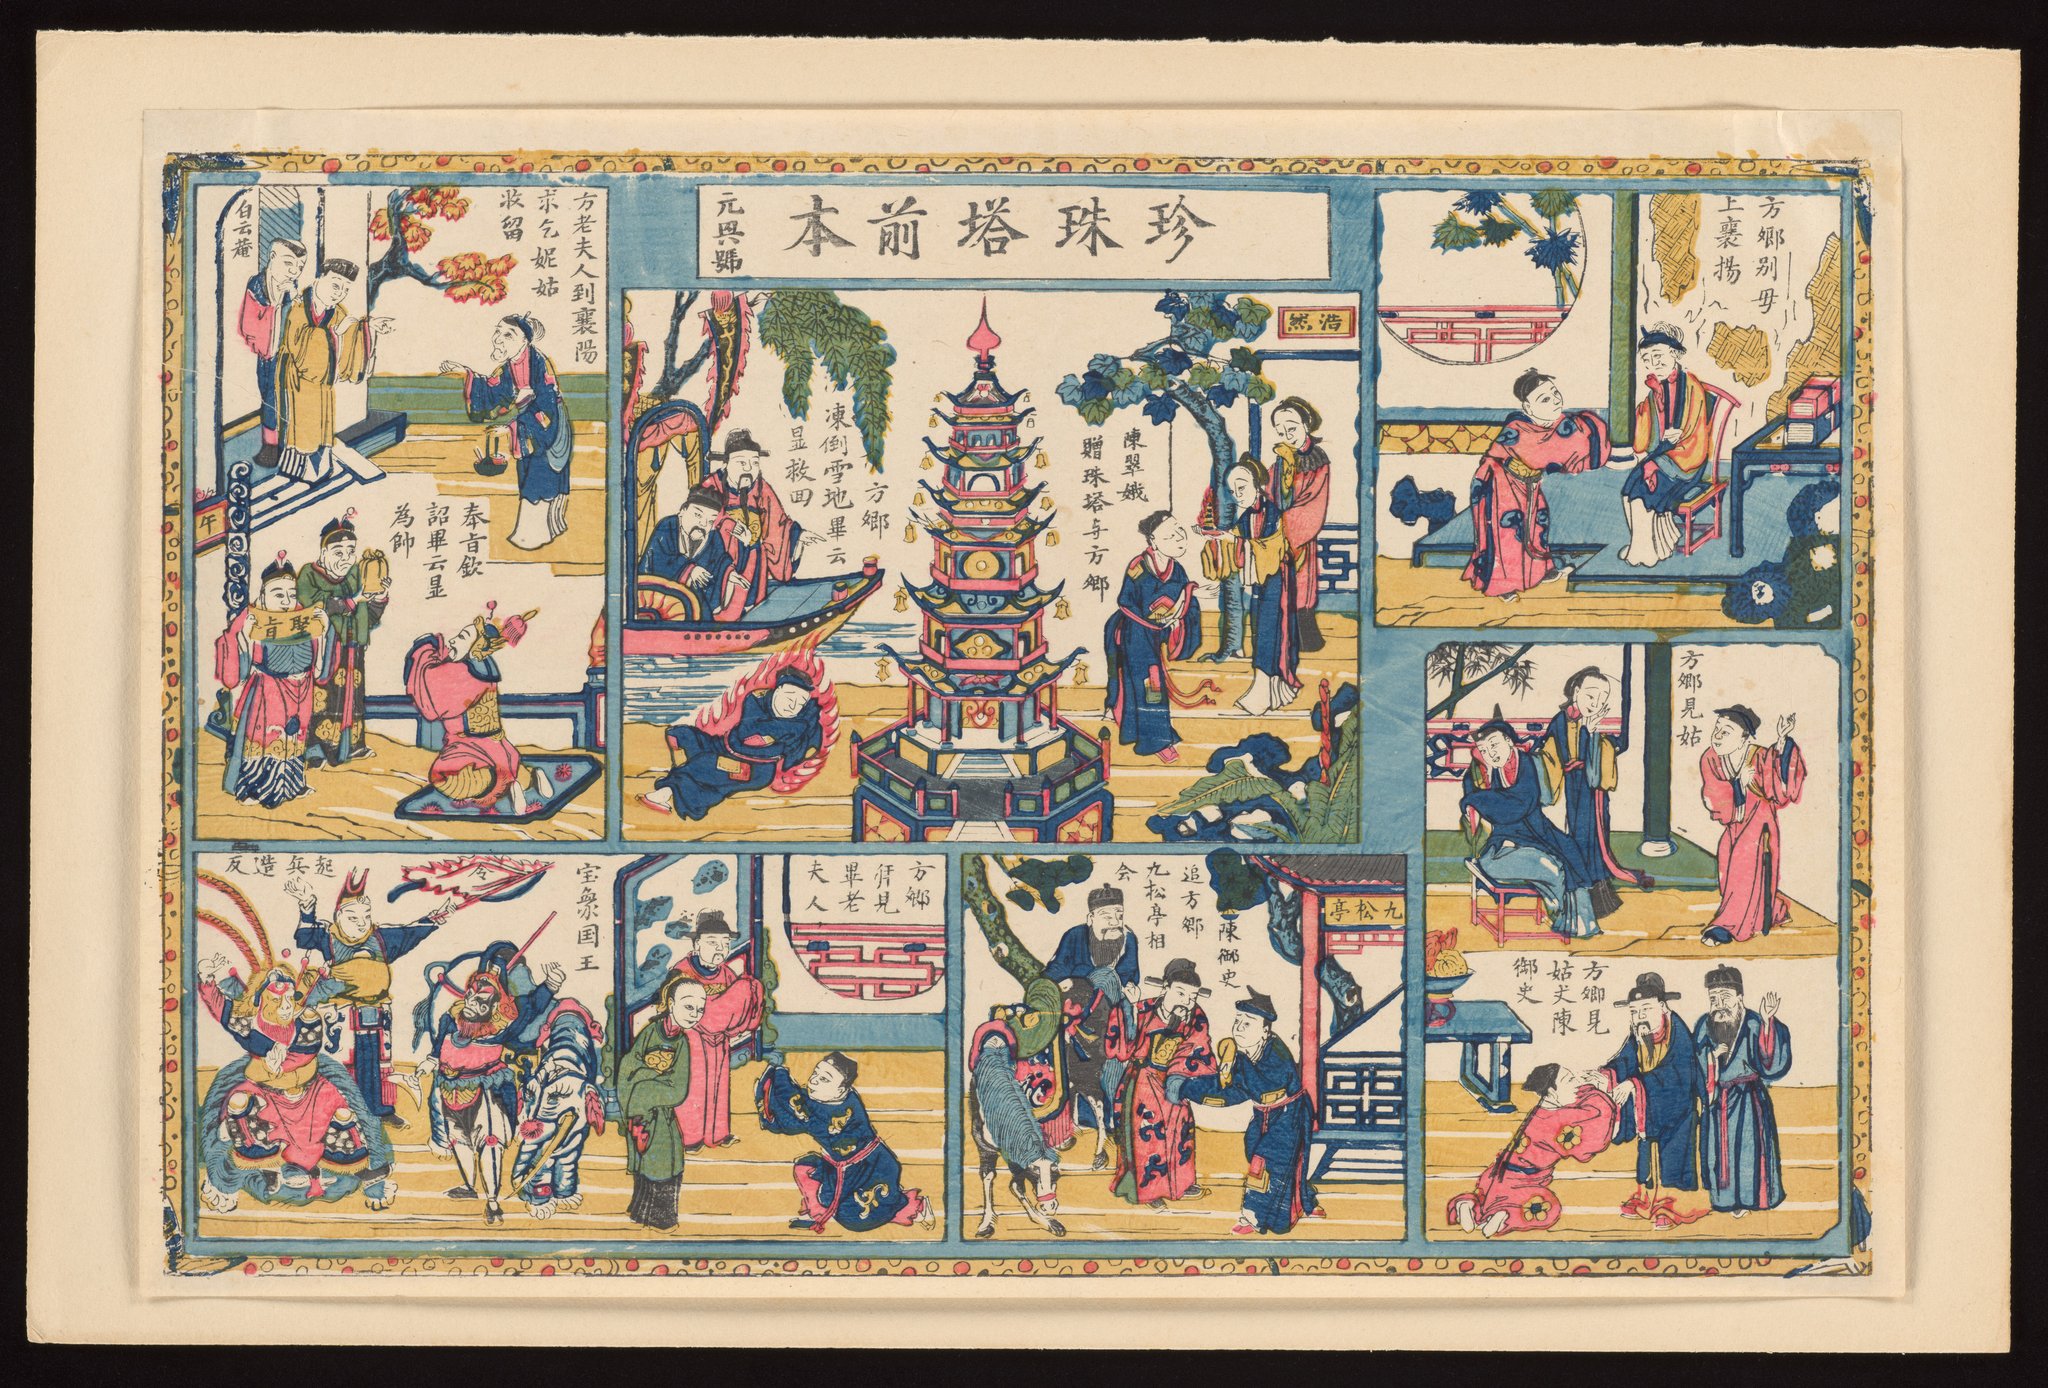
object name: print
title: Scenes from the First Part of Pearl Pagoda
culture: chinese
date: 1736-1795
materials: ink, paper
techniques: hand coloring, woodblock print